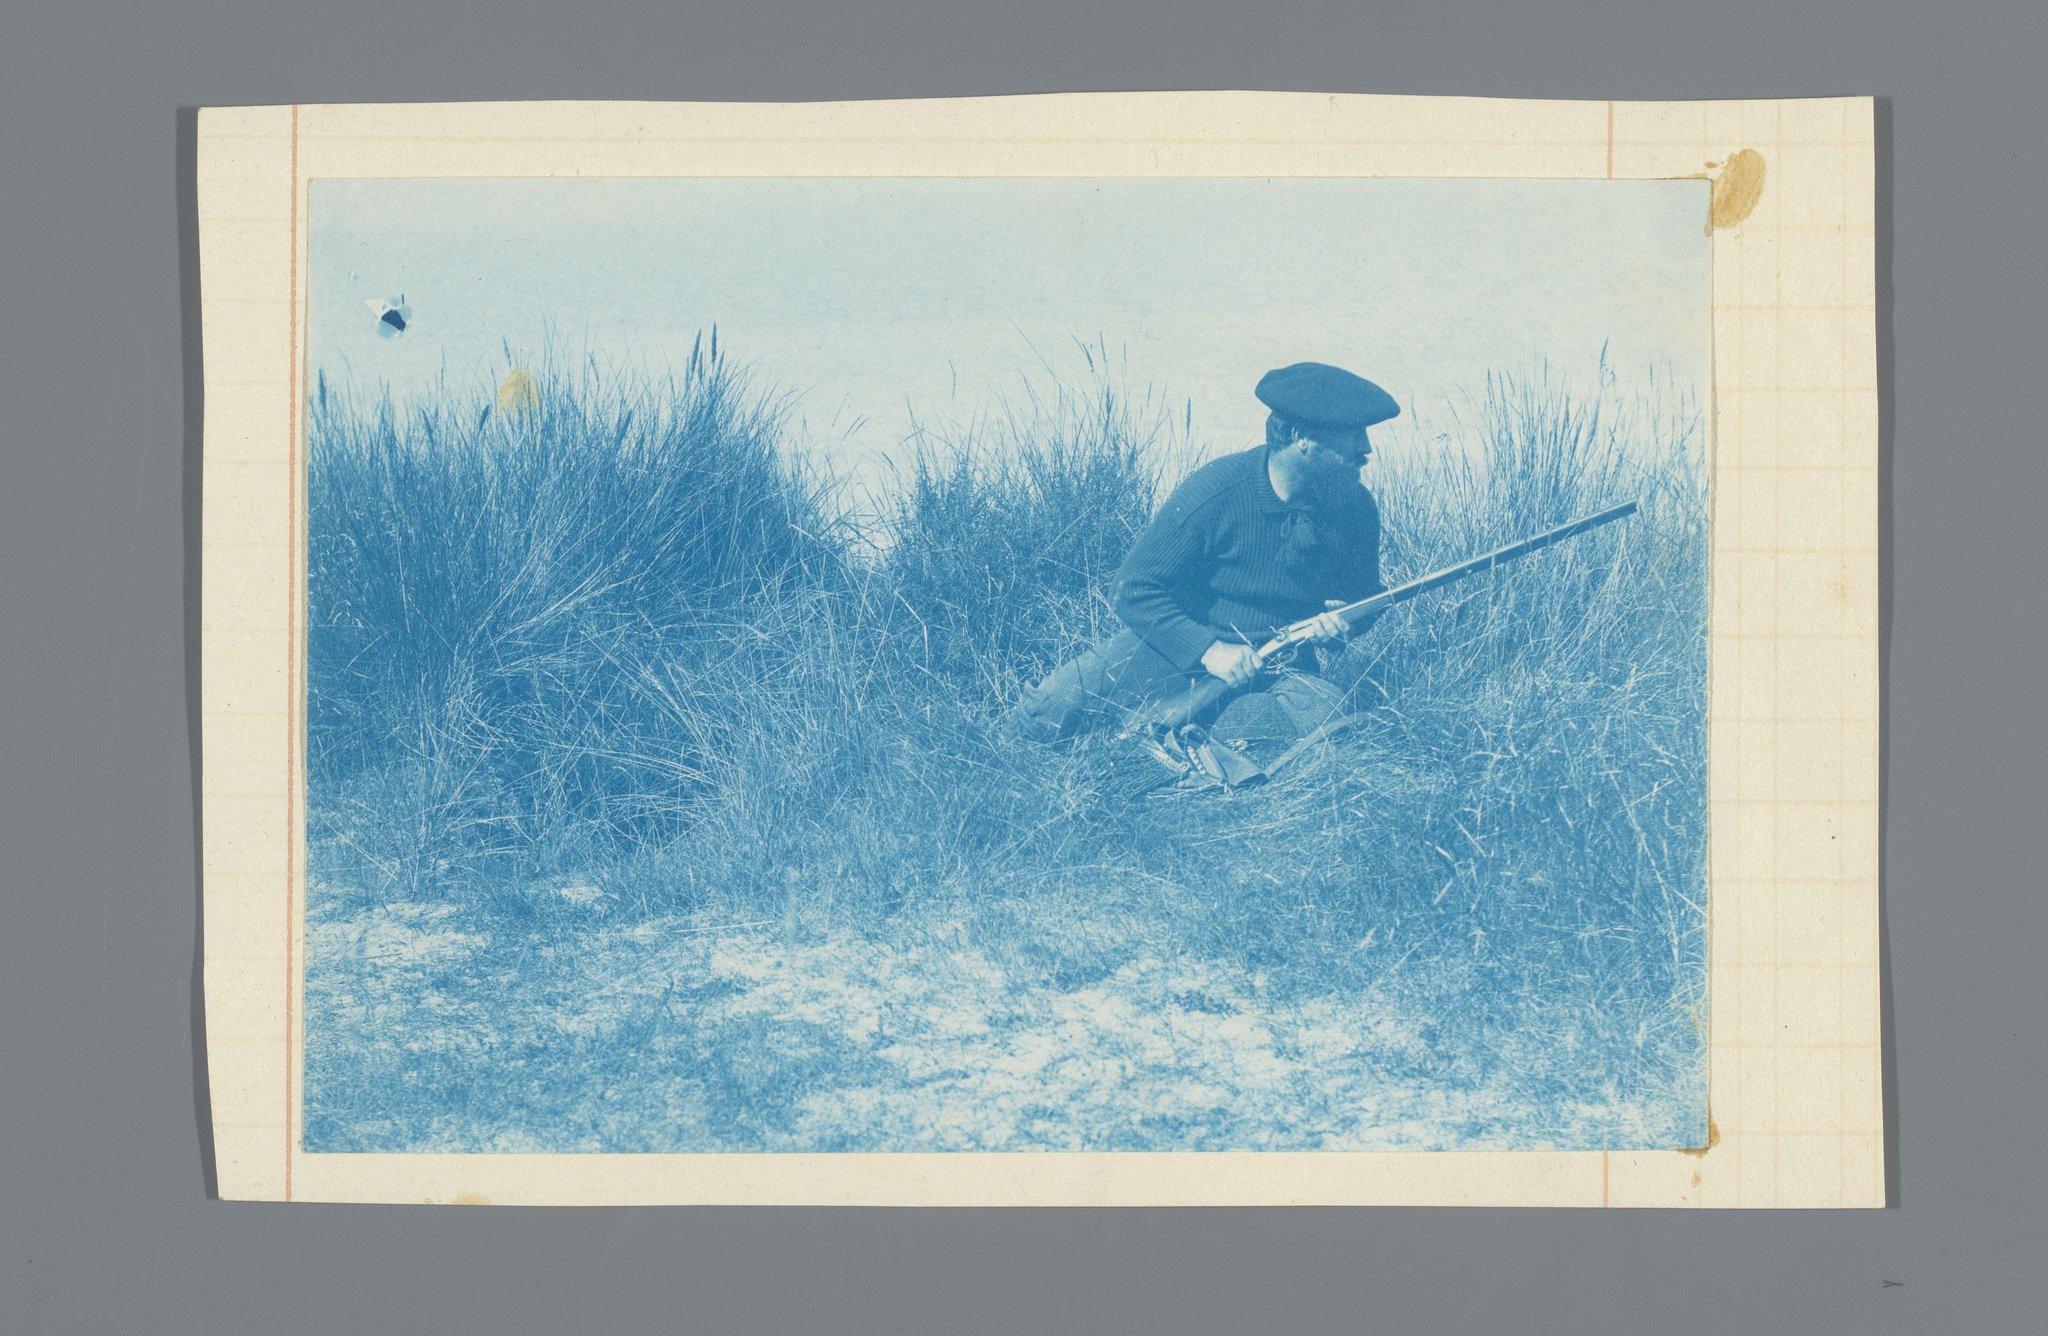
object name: photograph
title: Jager in de duinen, zittend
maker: Anonymous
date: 1880-1900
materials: paper, photographic support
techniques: cyanotype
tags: dune coast, hunting, chase